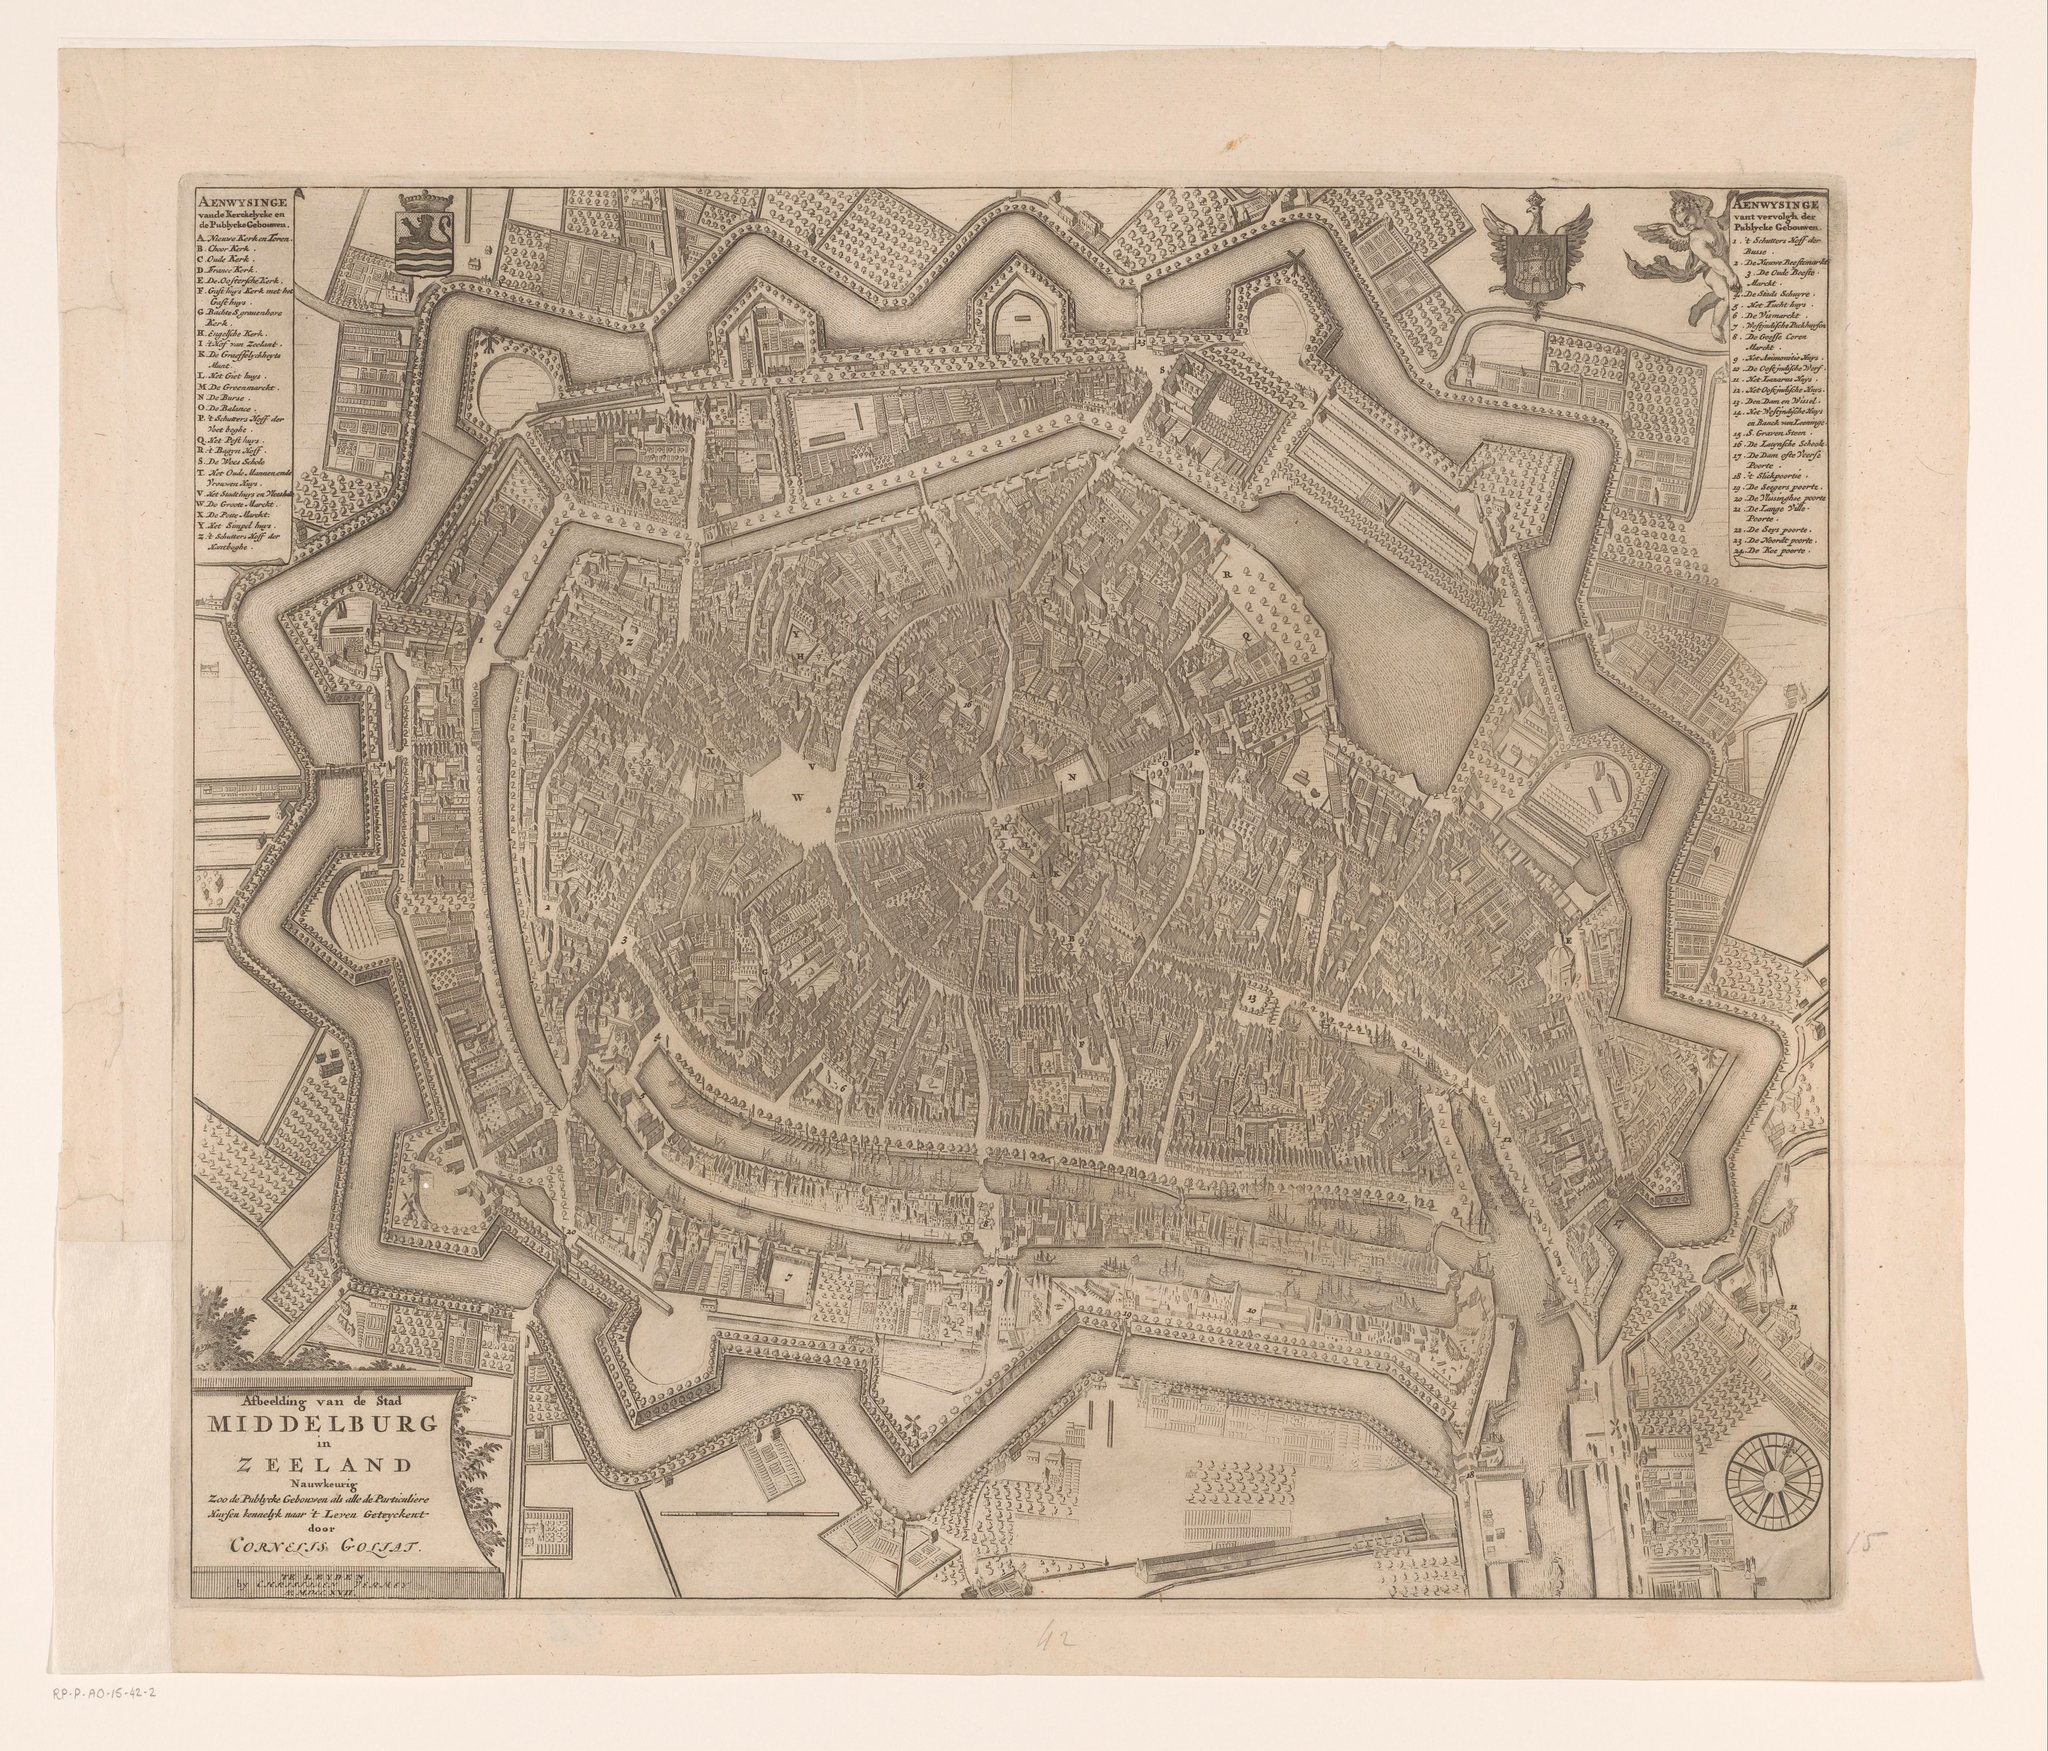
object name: print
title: Afbeelding van de stad Middelburg in Zeeland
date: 1690-1696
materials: paper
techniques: engraving, etching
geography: leiden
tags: coat of arms (as symbol of the state, etc.) (+ city; municipal), maps of cities, coat of arms (as symbol of the state, etc.) (+ province; provincial), middelburg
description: Cornelis Goliath zou de tekening voor deze plattegrond, die pas na zijn dood in druk zou verschijnen, in 1656-1657 hebben gemaakt. Landmeter Anthony van Meyren kreeg in 1688 betaald om de tekening bij te werken en in 1690 is de plaat gegraveerd. Deze eerste staat van de plattegrond (zie RP-P-AO-15-42-1) is vervolgens ook gebruikt in: Smallegange, Mattheus. Nieuwe Cronyk van Zeeland (…). Middelburg en Amsterdam: Johannes Meertens en Abraham van Someren, 1696. De huidige prent is een latere staat.